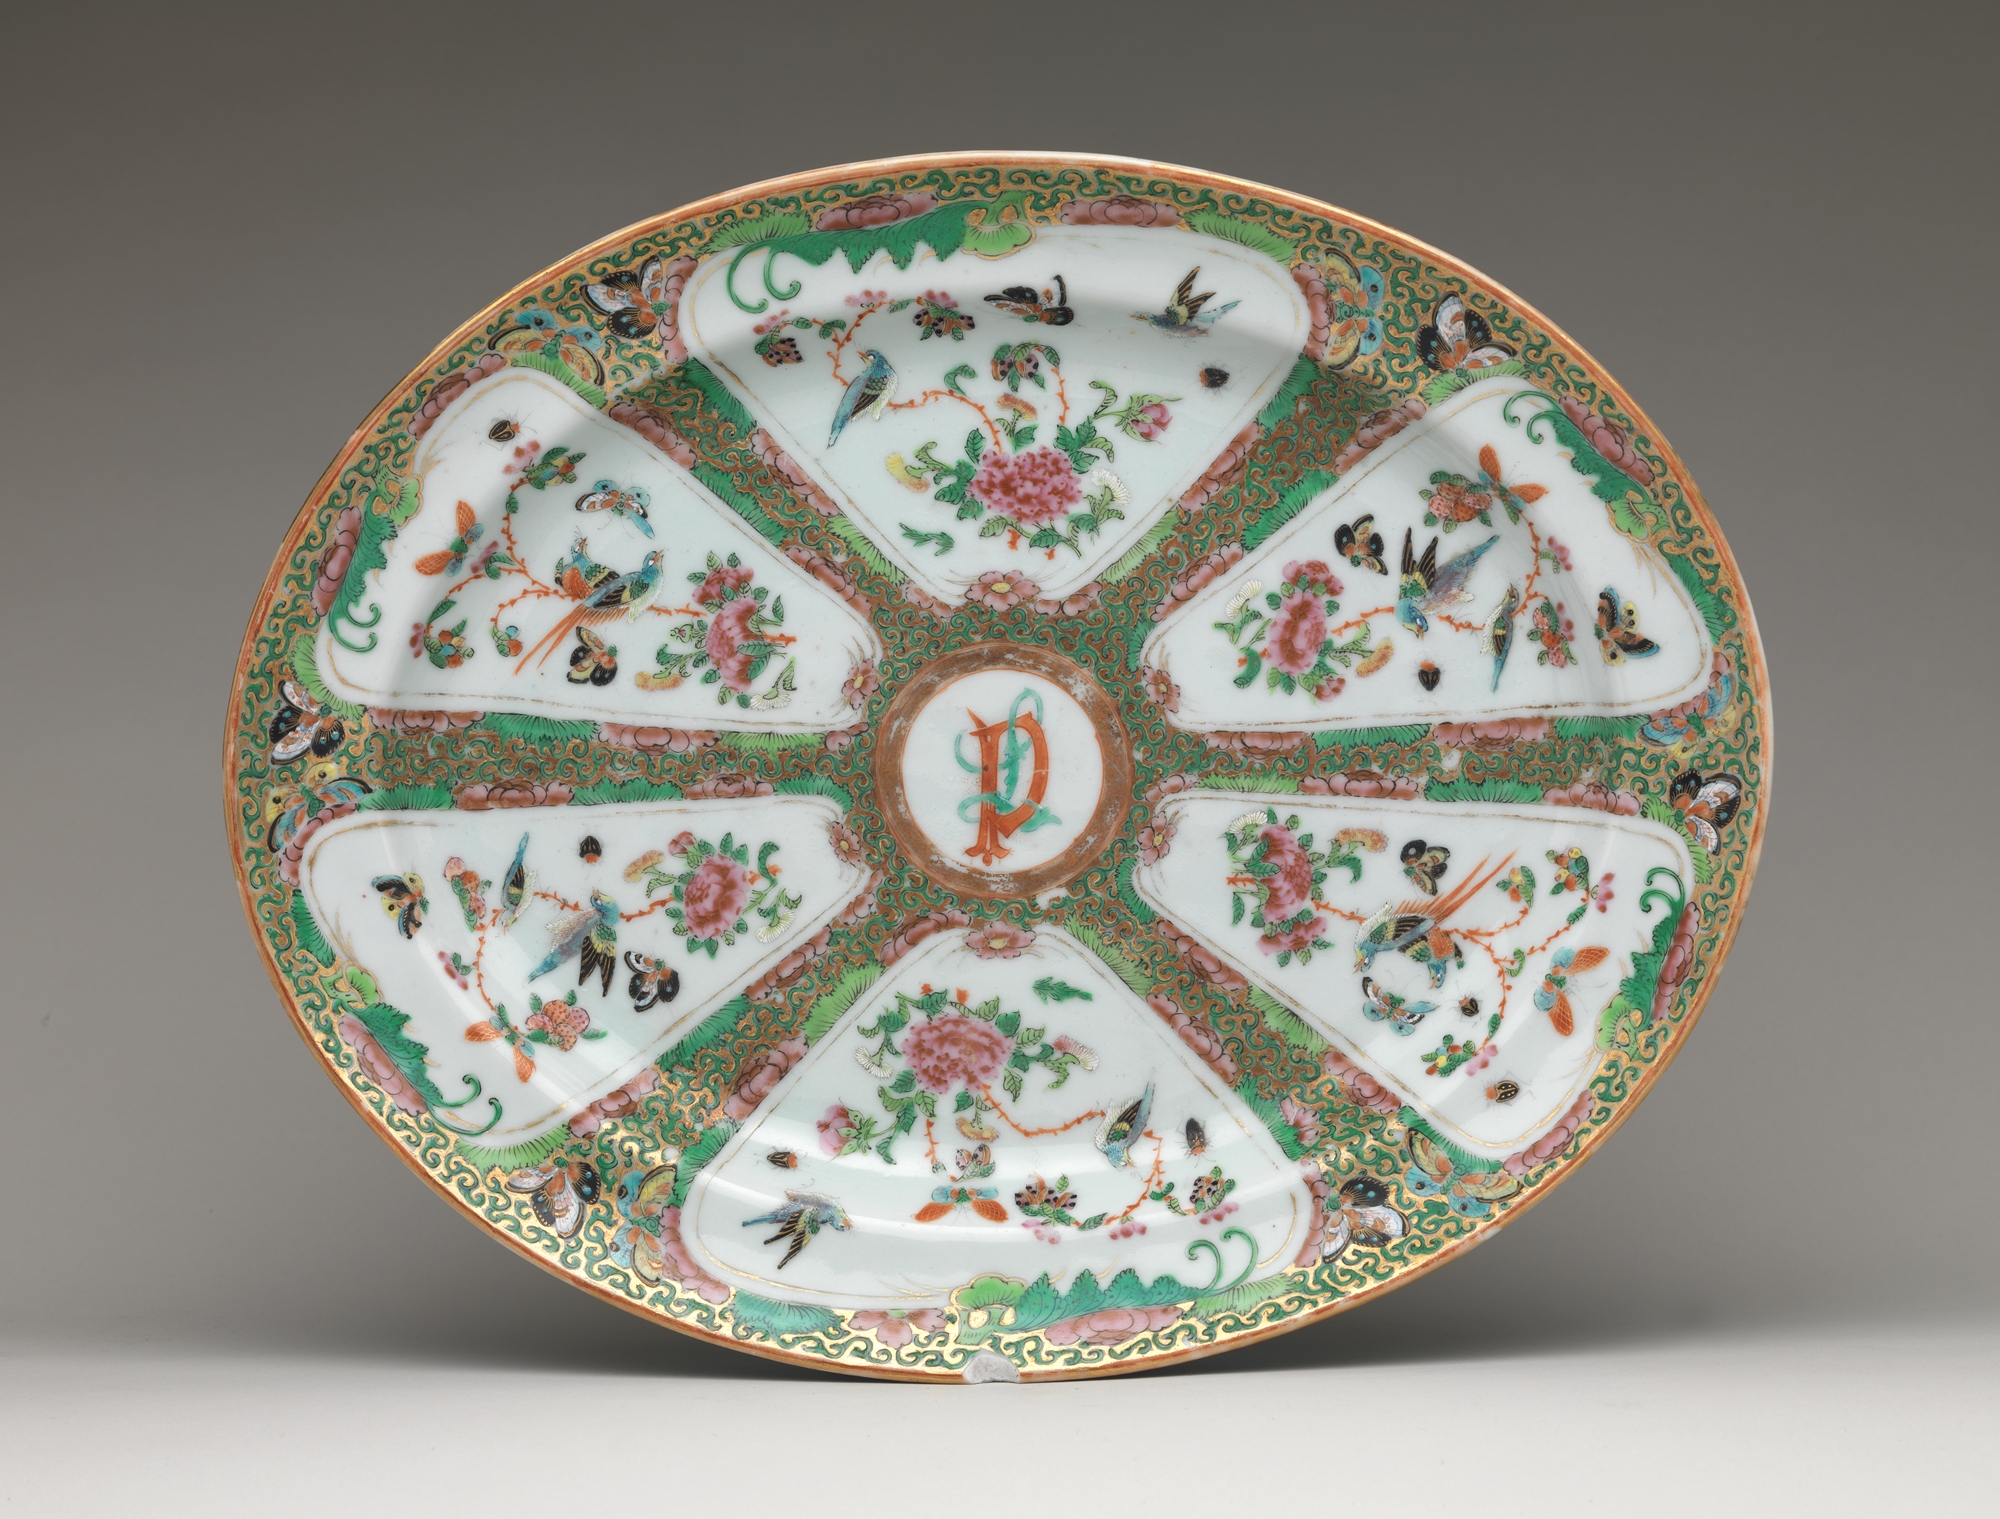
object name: platter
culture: chinese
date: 1860-1866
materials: porcelain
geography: china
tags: birds,butterflies,flowers